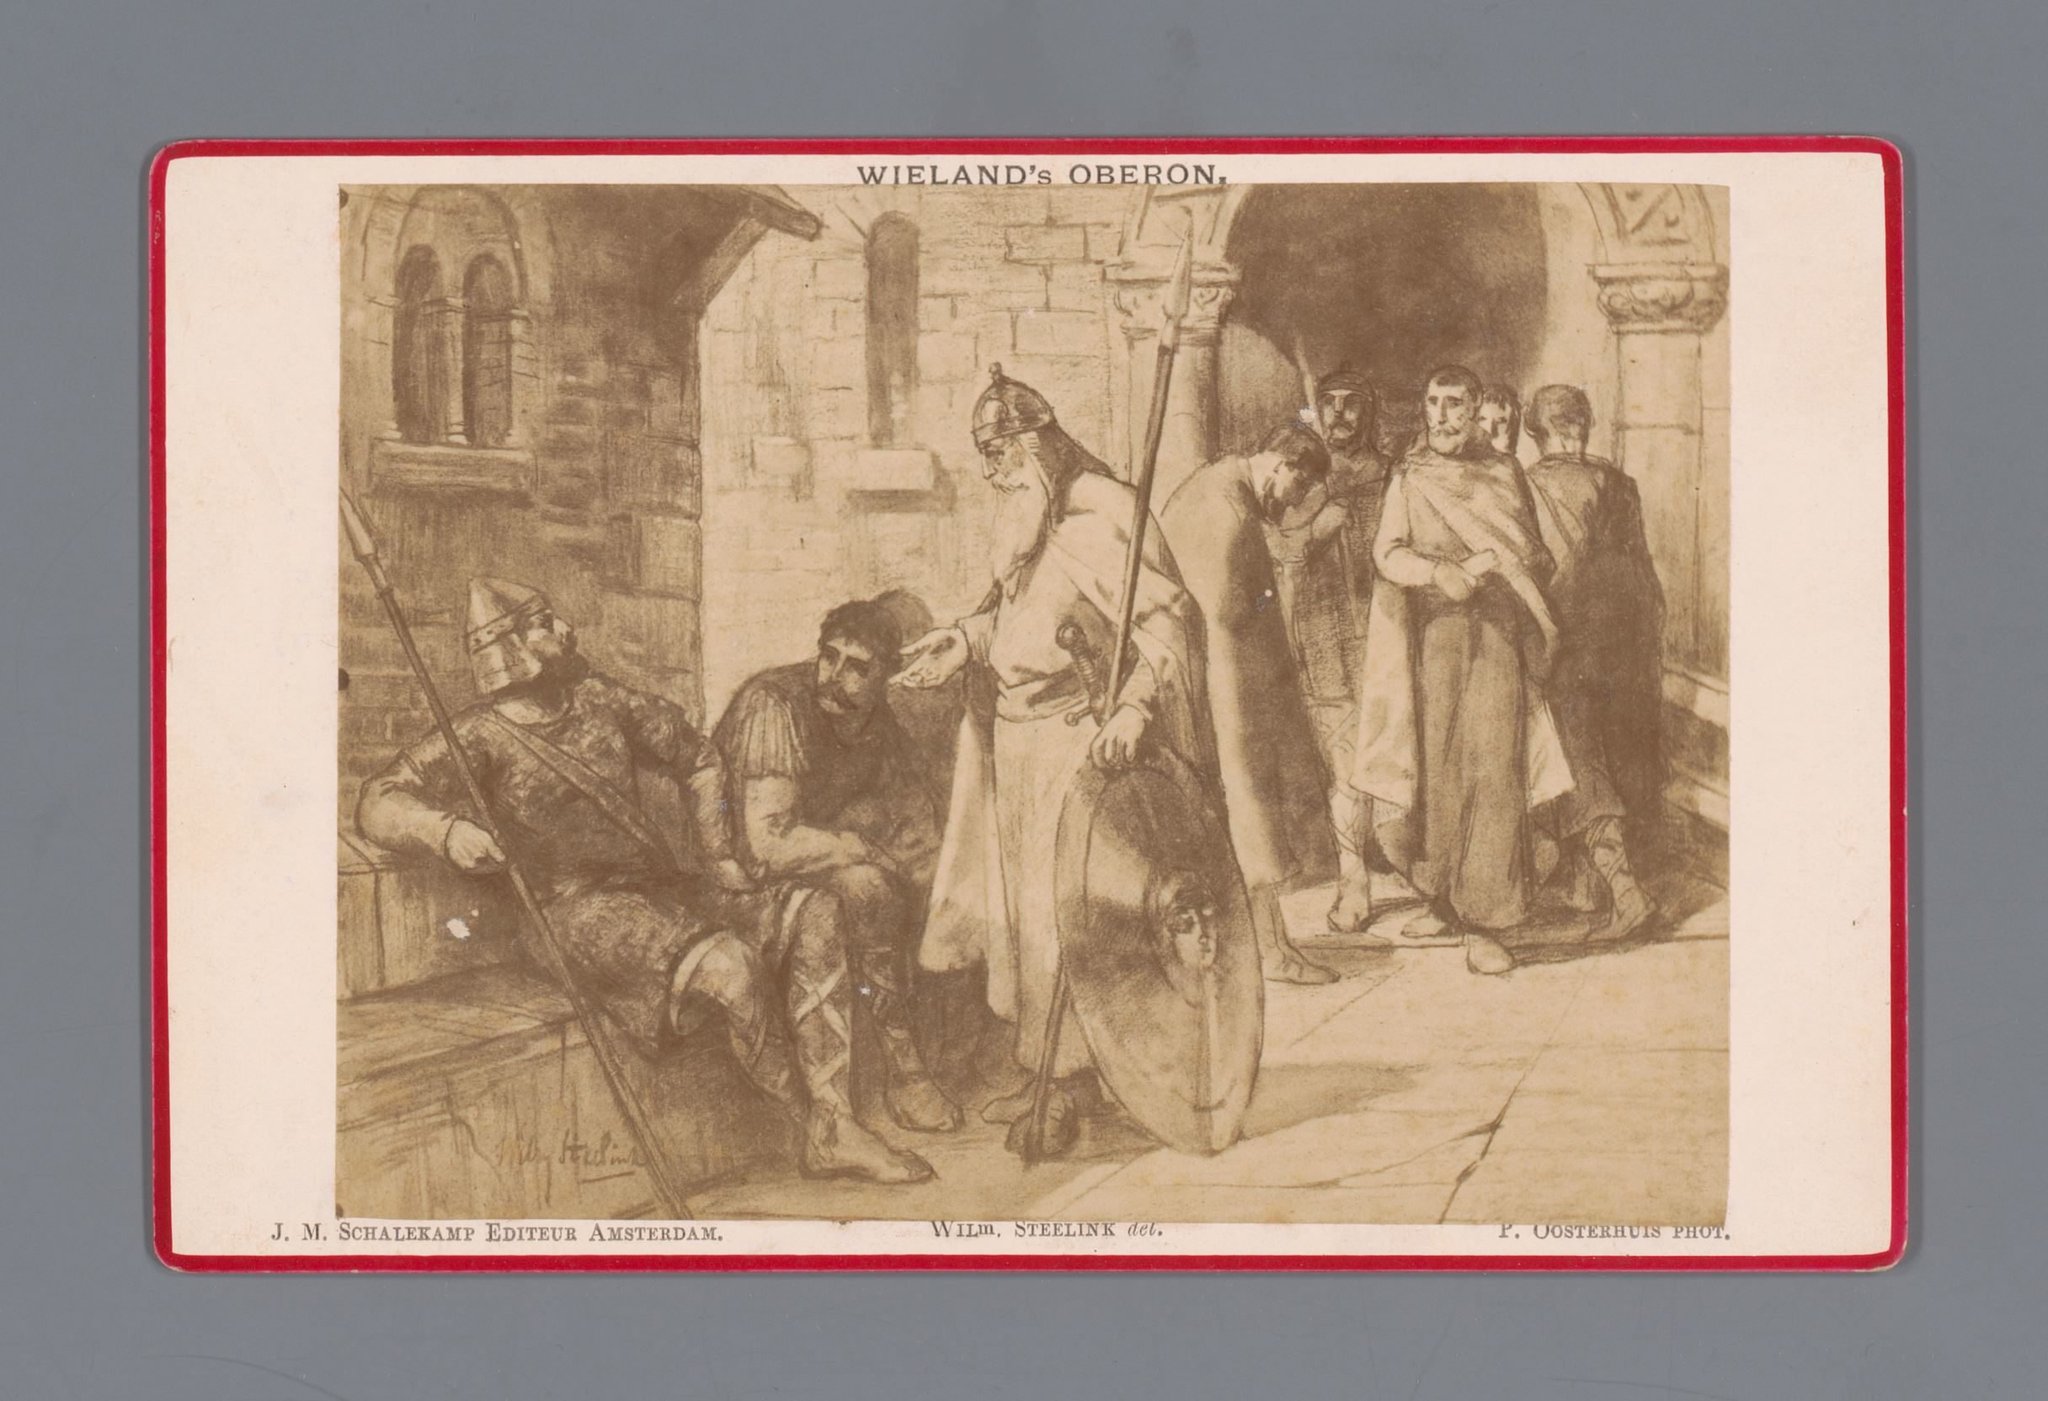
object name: photograph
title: Fotoreproductie van een tekening, voorstellende Huon de Bordeaux praat met twee ridders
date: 1875-1900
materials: cardboard, photographic support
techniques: albumen print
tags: knight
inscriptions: number: ‘8’